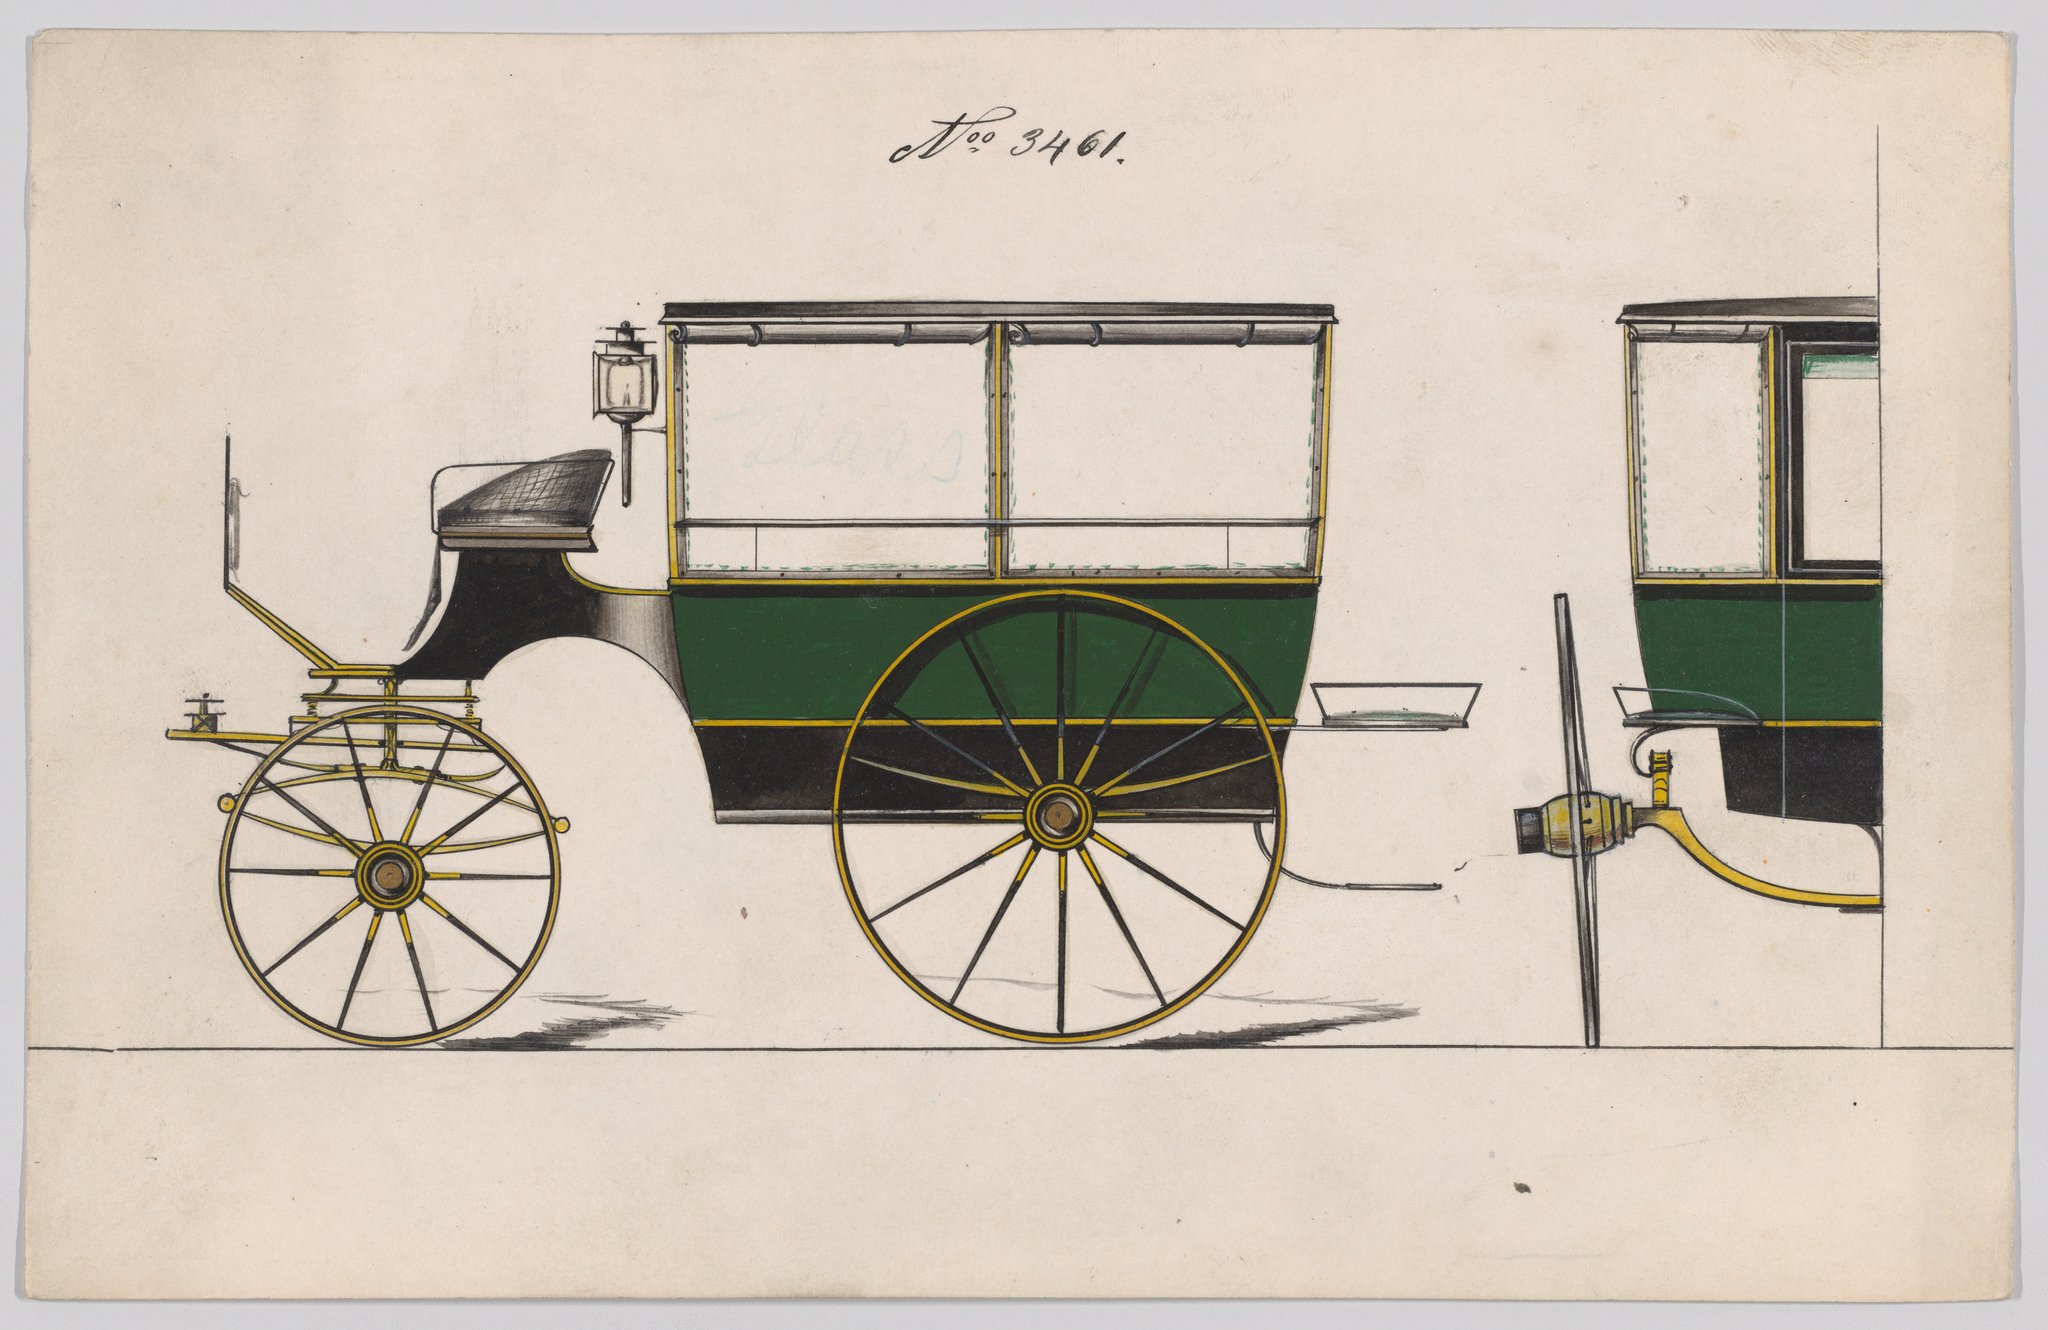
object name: drawing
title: Design for Omnibus or Wagonette, no. 3461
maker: brewster & co.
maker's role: manufacturer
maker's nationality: american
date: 1878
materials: gouache, gum arabic, ink, watercolor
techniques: pen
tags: carriages